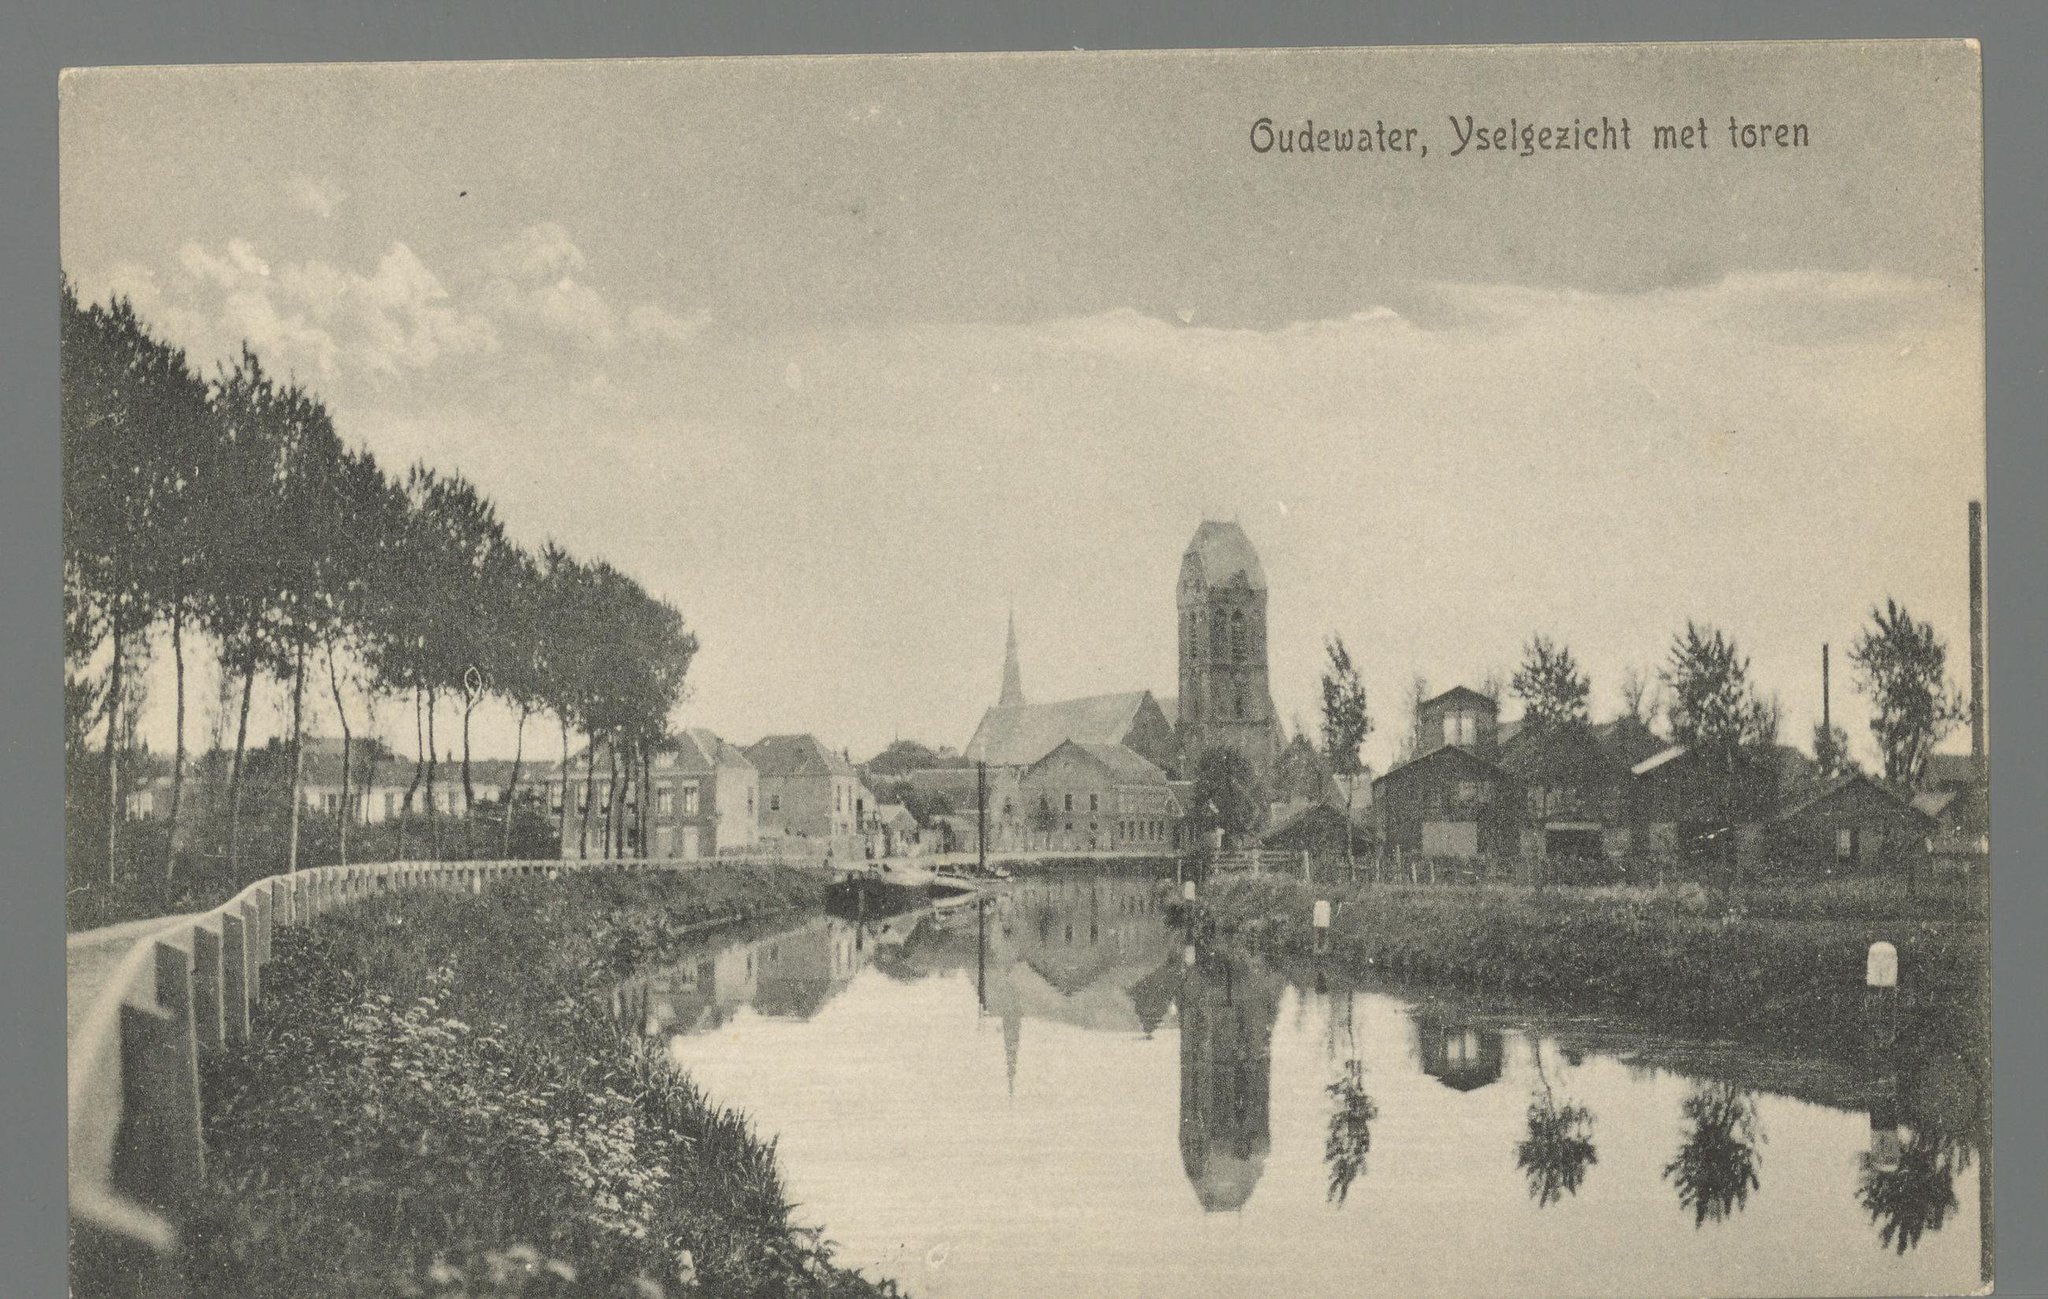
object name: photomechanical print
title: Oudewater, Yselgezicht met toren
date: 1905-1930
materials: cardboard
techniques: photograph, writing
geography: oudewater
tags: city-view, and landscape with man-made constructions, river, church (exterior)